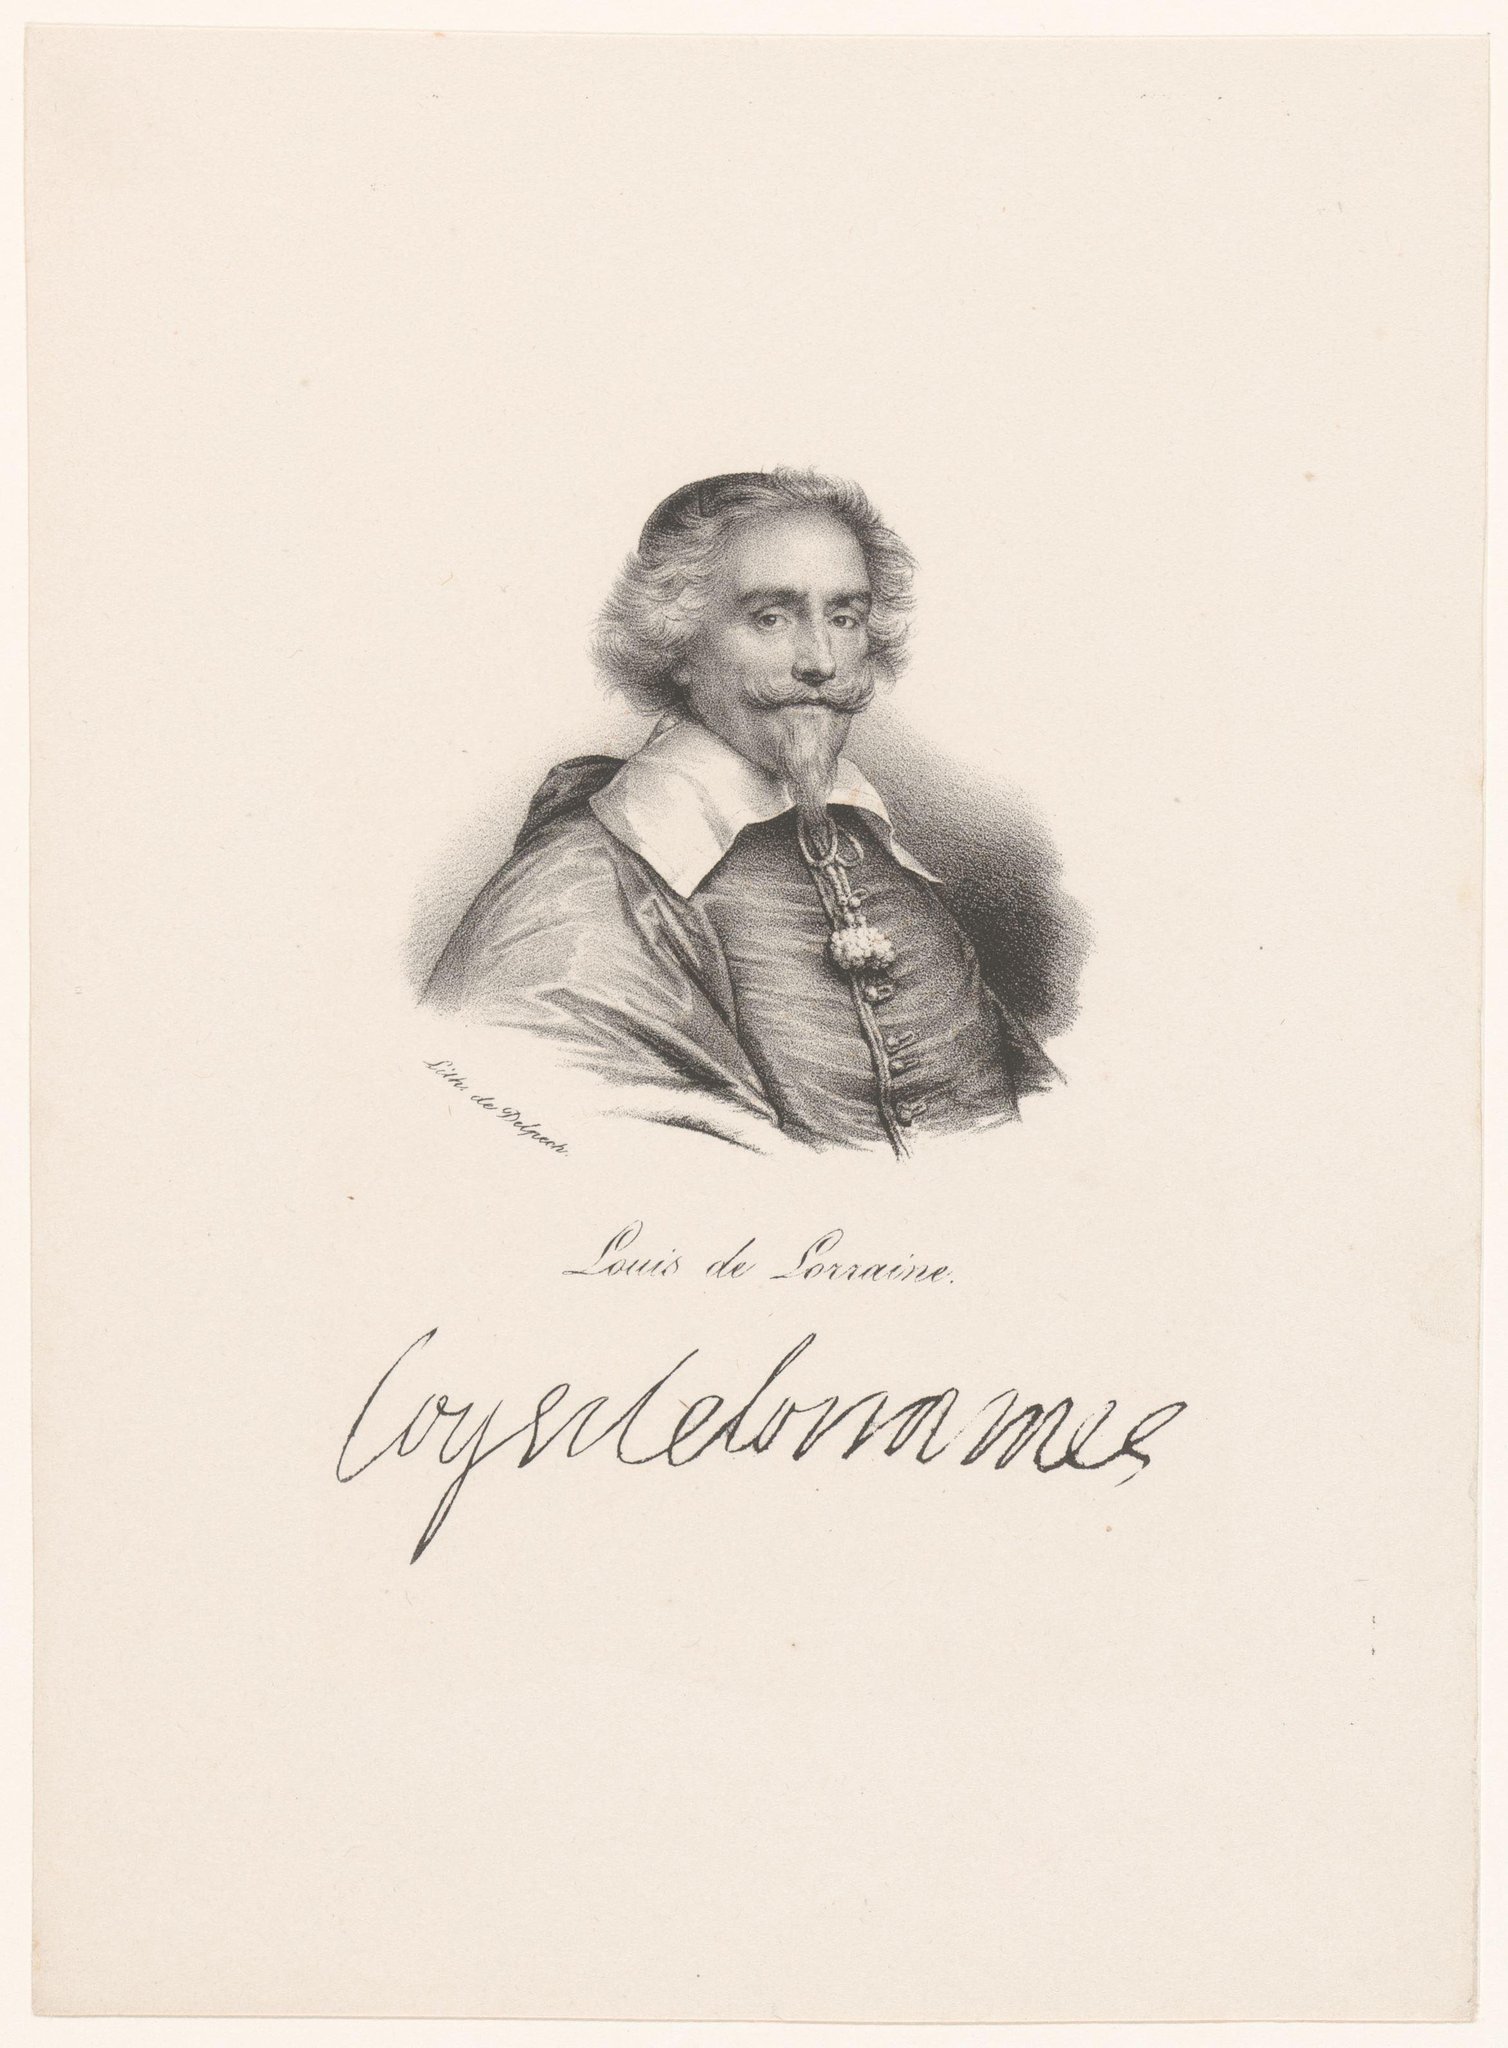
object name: print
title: Louis de Lorraine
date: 1818-1842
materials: paper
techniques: lithograph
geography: paris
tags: historical persons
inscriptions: collector's mark: Lugt 2228a